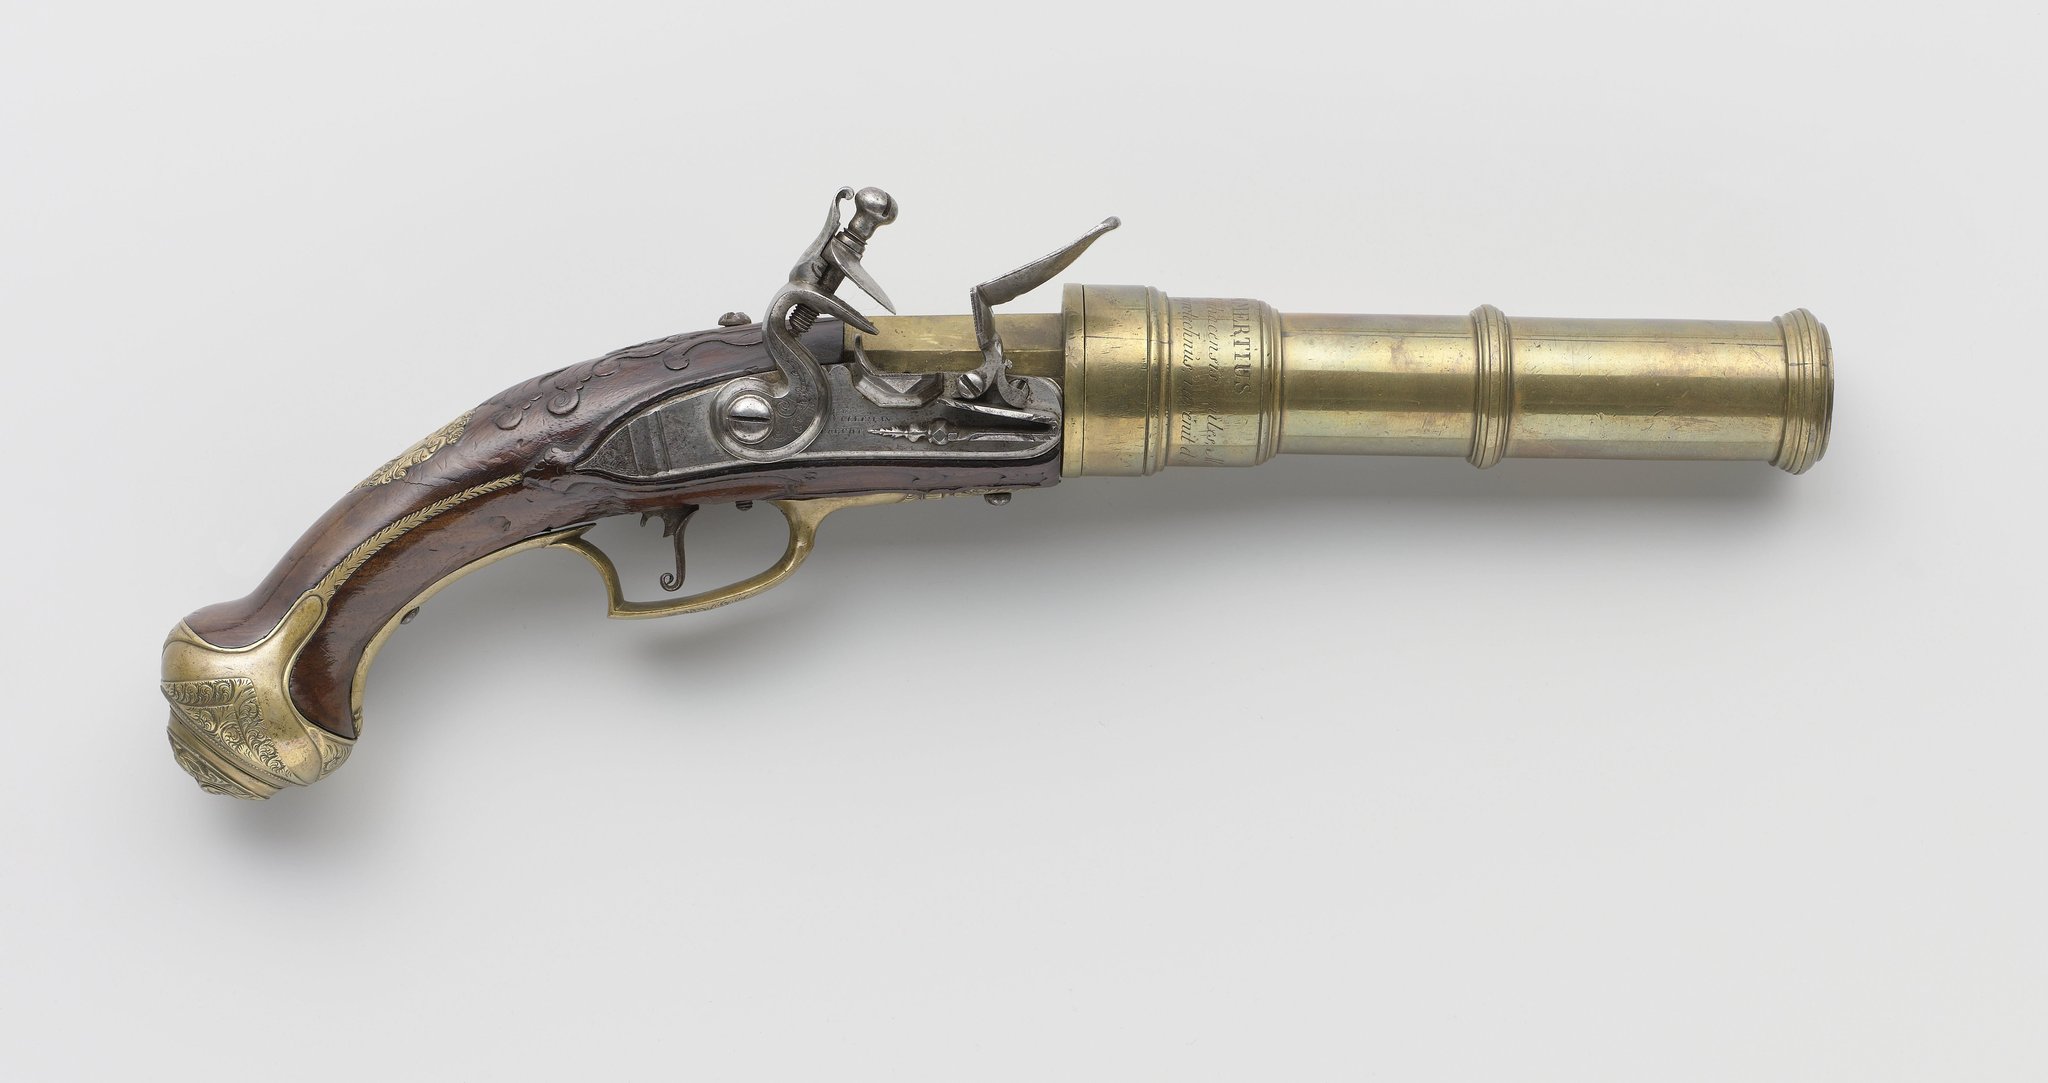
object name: pyrotechnisch wapen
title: Pyrotechnic flintlock pistol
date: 1744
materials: brass, wood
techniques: printing, metalworking, cutting, engraving, gilding, relief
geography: jülich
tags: netherlands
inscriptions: inscription: ‘IACOBUS LOMMERTIUS // : // Juliacensis miles, Mathematicus, Mechanicus // ac // pijrotechnicus invenit et omnino paravit me anno 1774’, signature: ‘J NELLEMAN // UTRECHT’, mark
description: Firework technology was also applied in pistols, allowing them to fire signals, or shoot burning projectiles into encampments of enemy tents or ships’ sails. The inscription on the barrels freely translates as: ‘Jacob Lommers, soldier of Jülich, mathematician, engineer and pyrotechnician, conceived and made me in my entirety in the year 1744.’